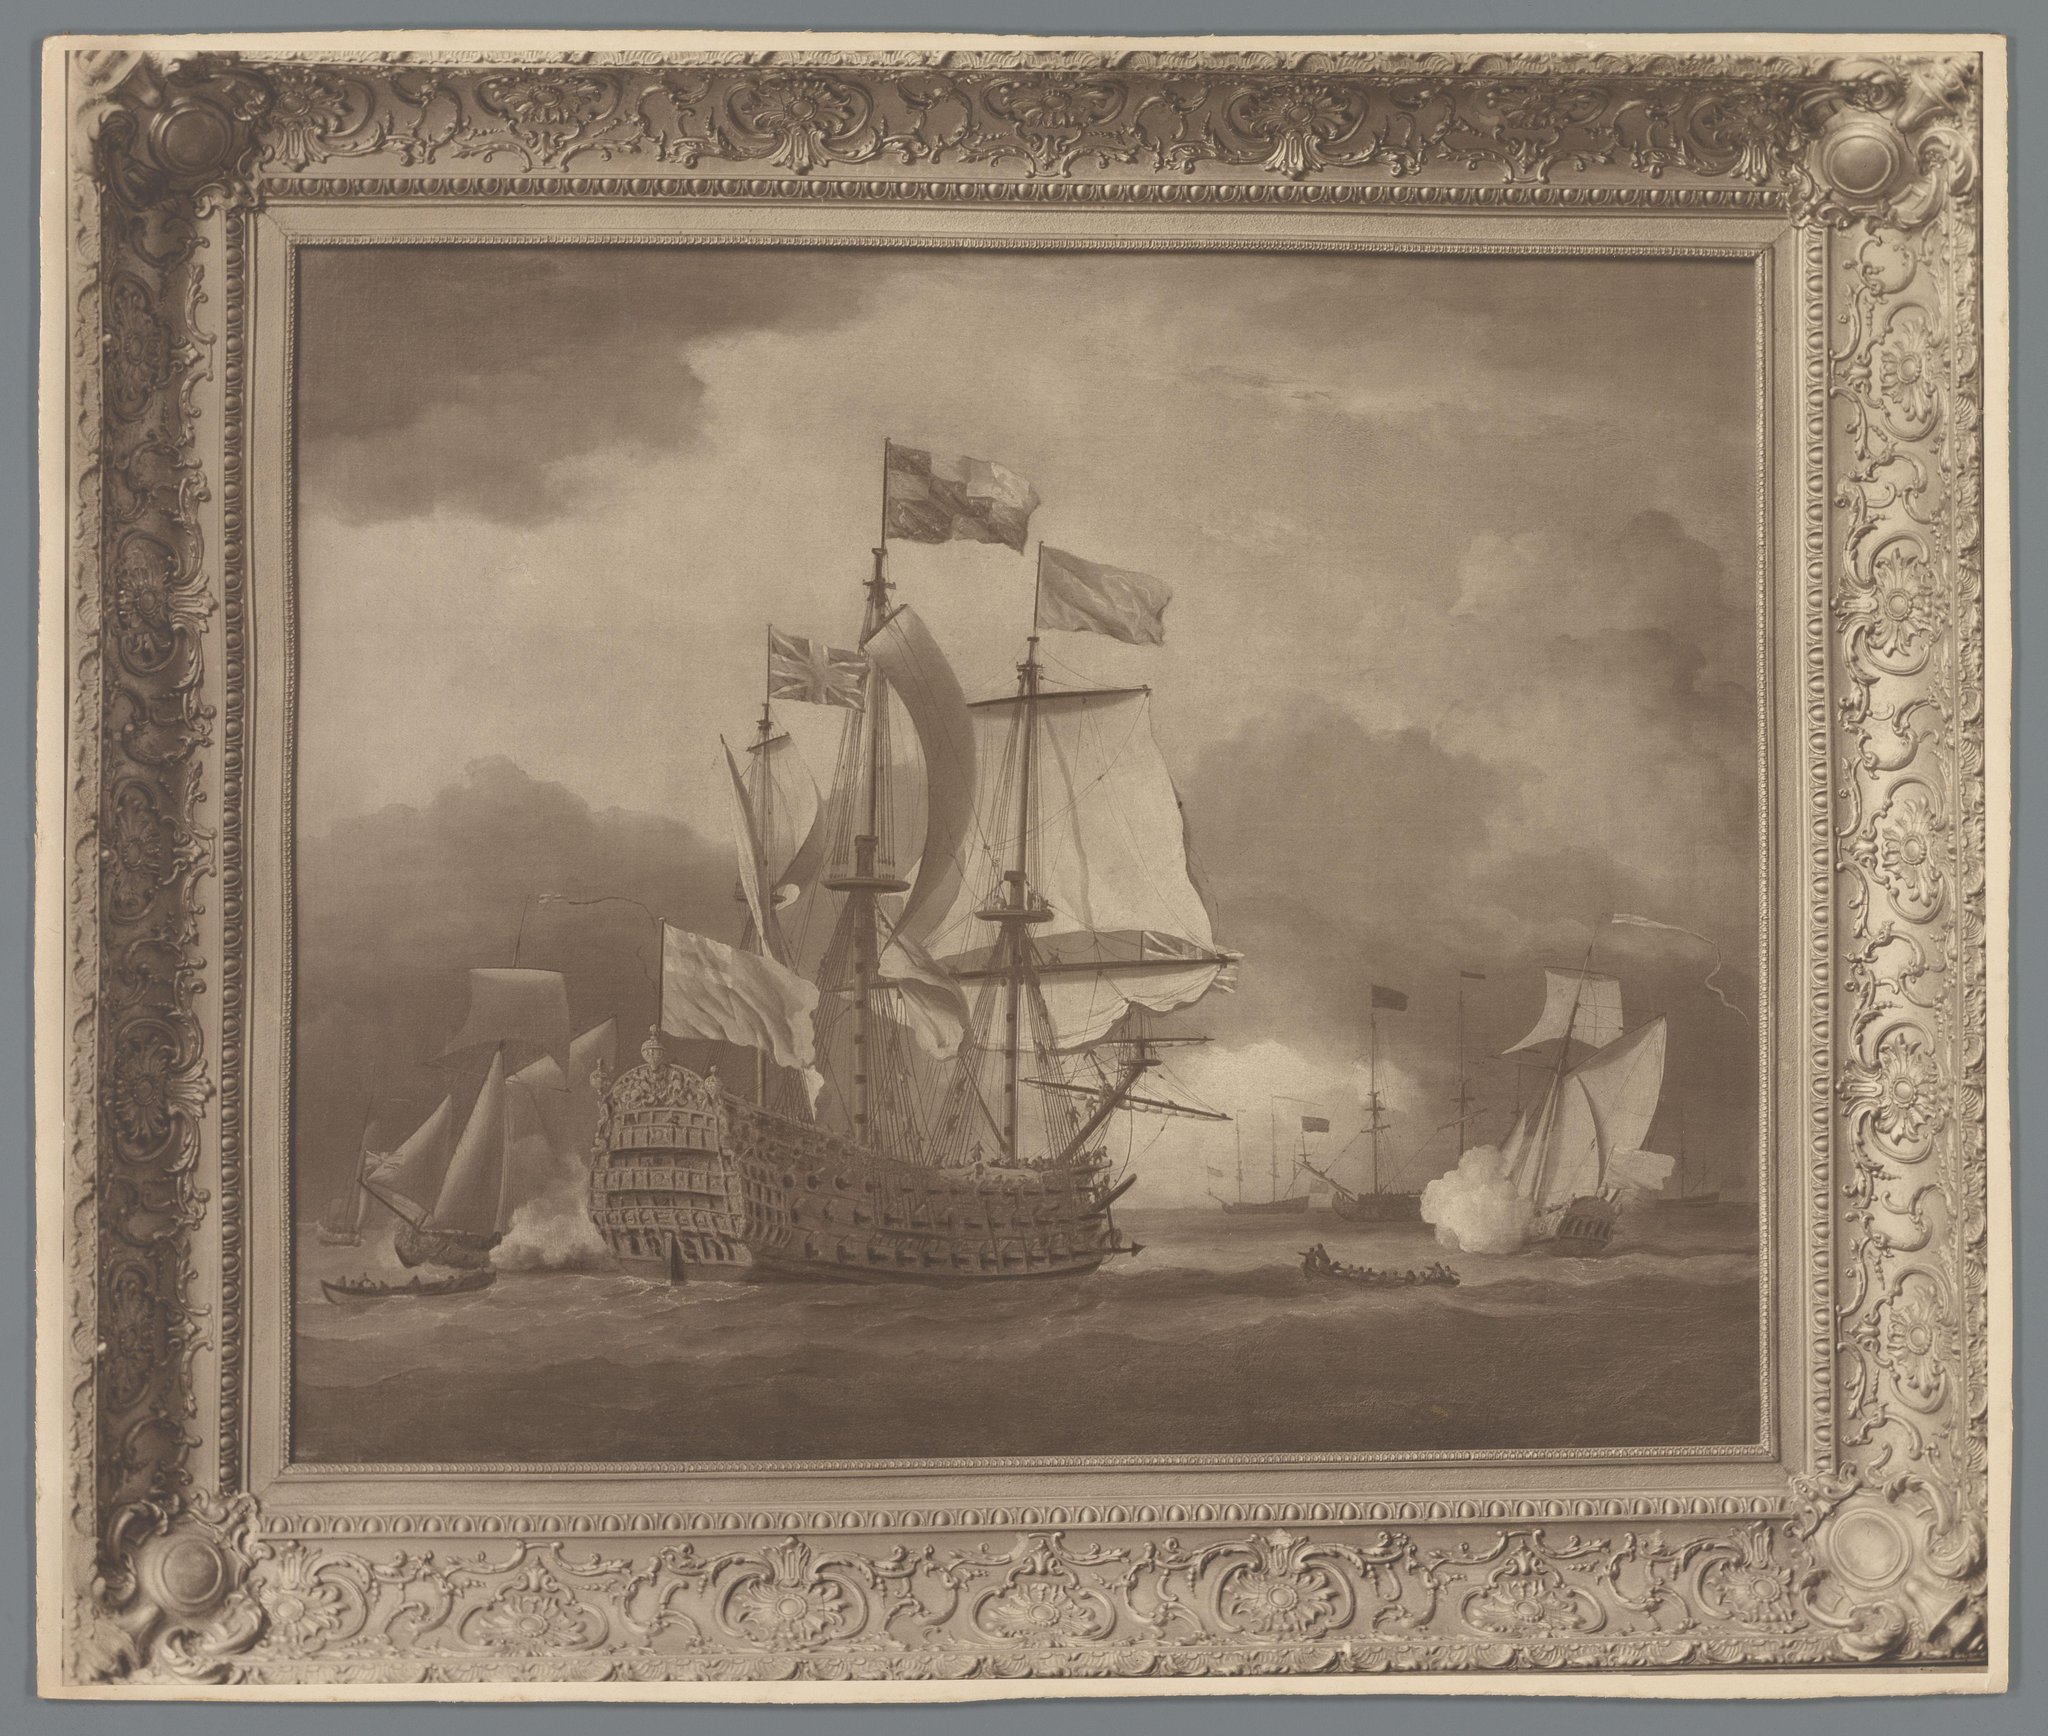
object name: stereograph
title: Gezicht op de Vrijdagmarkt in Gent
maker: bt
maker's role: fotograaf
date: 1861-1870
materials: cardboard, paper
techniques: albumen print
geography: ghent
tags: square, place, circus, etc., urban housing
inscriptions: inscription: ‘Flandre Orientale./ Gand. Pop. 100,000 hab.’, number: ‘59.’, number: ‘No 59.’